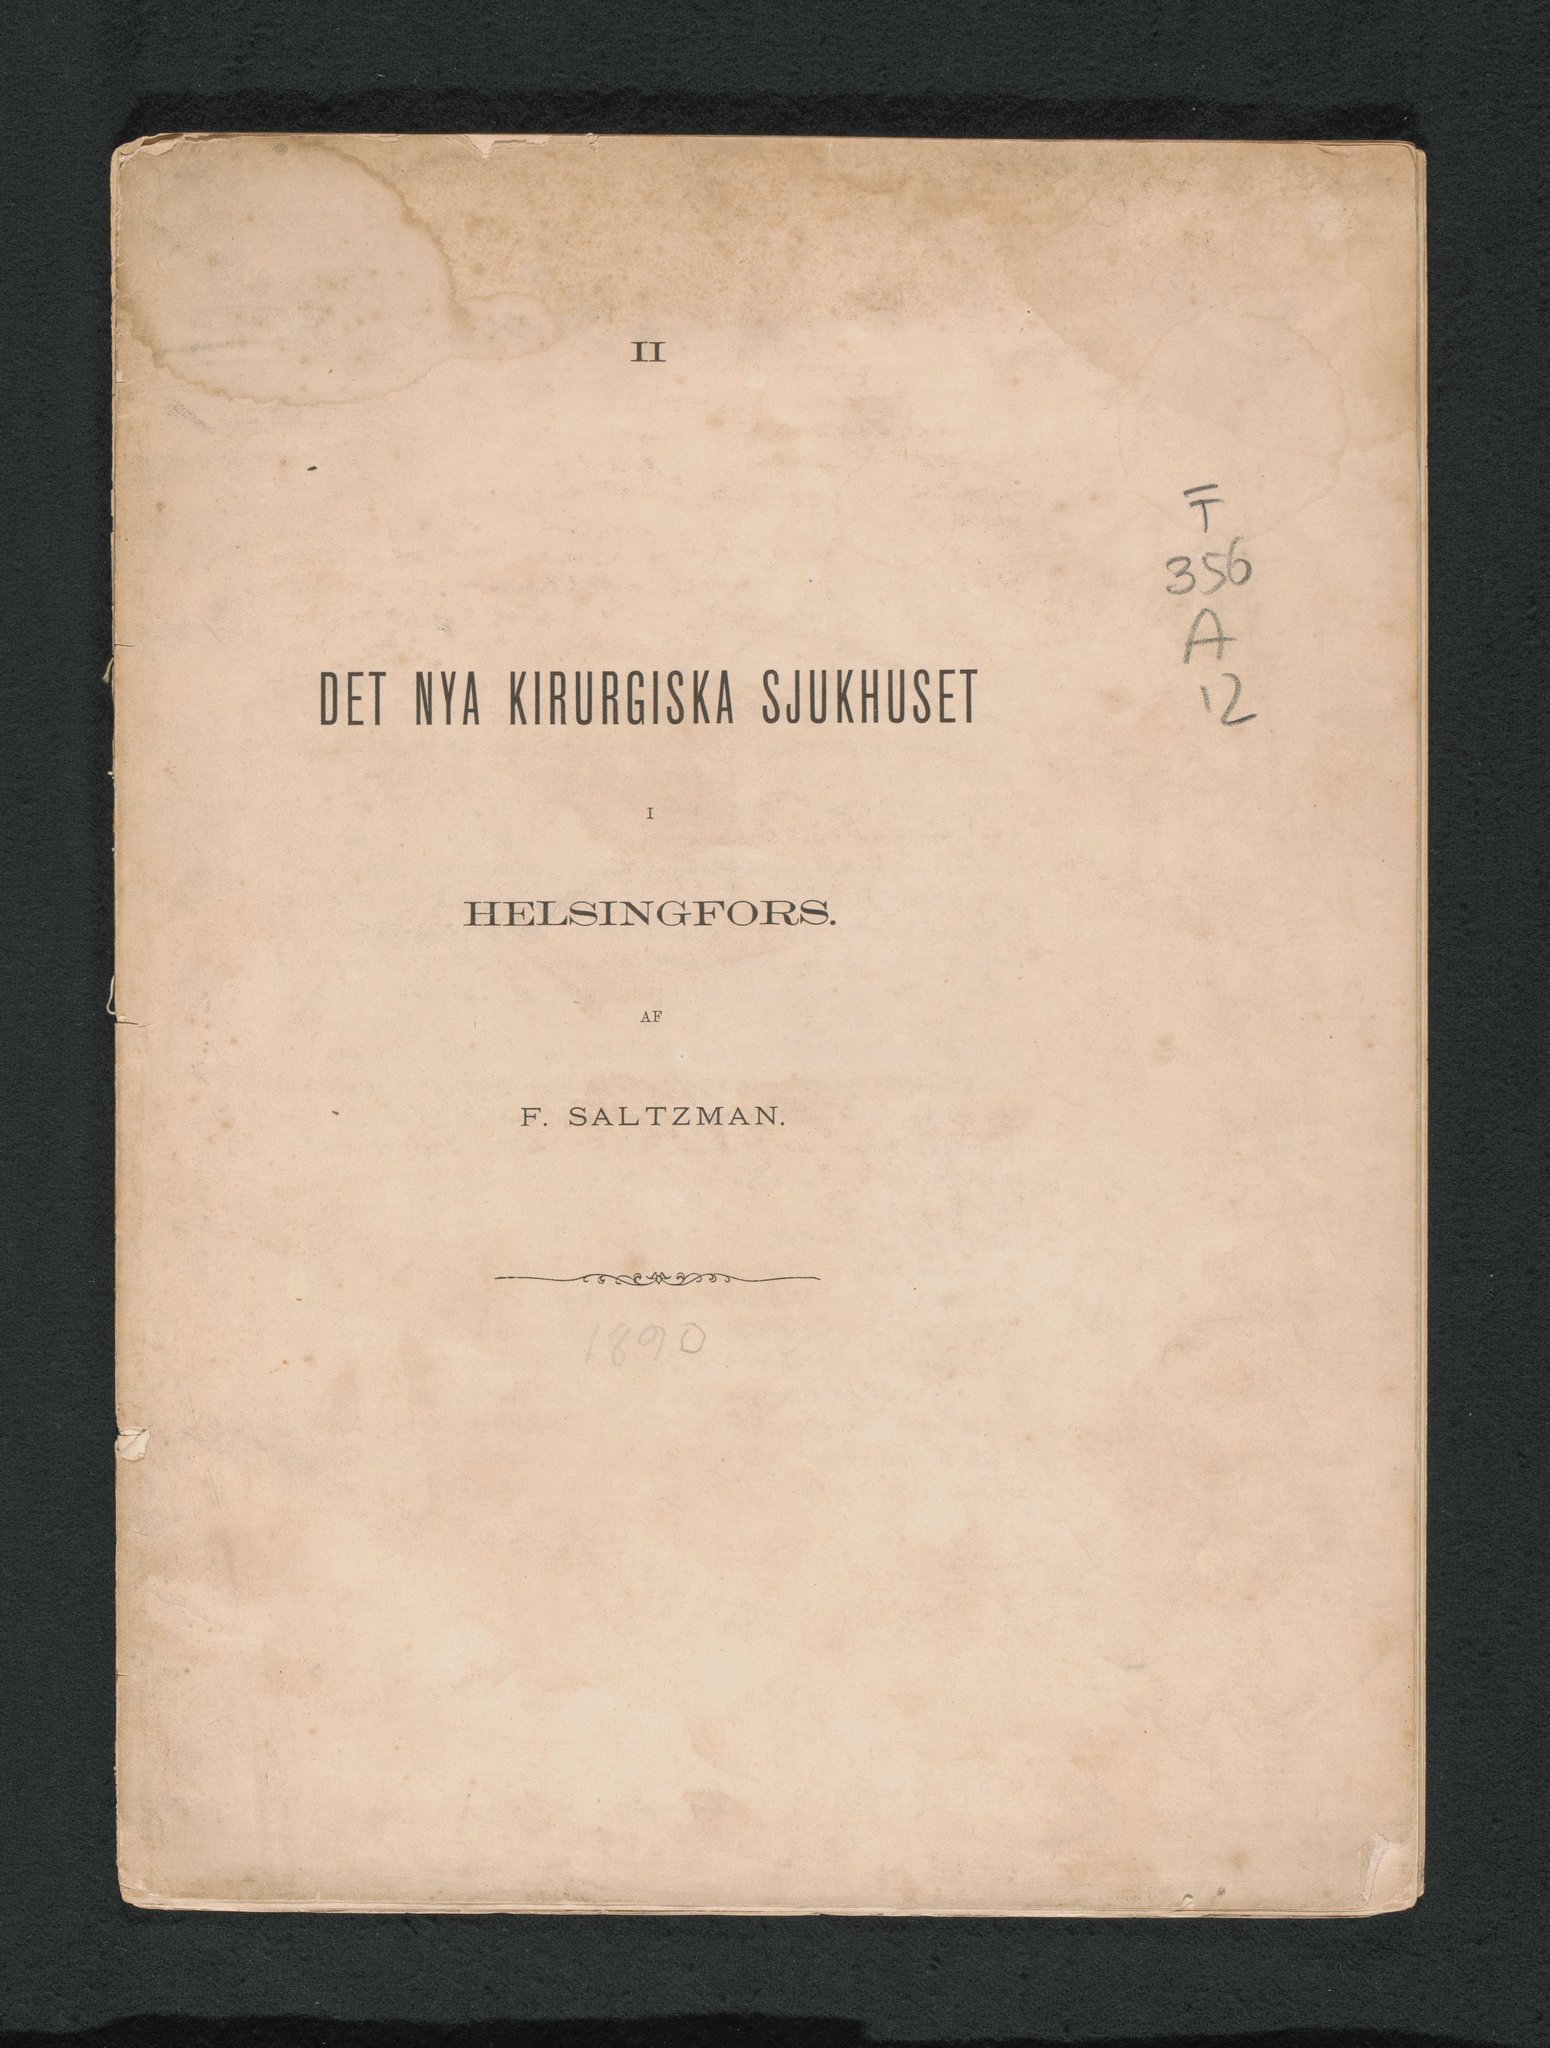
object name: book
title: Det nya kirurgiska sjukhuset i Helsingfors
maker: f. saltzman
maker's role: schrijver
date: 1890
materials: paper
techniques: photograph, printing